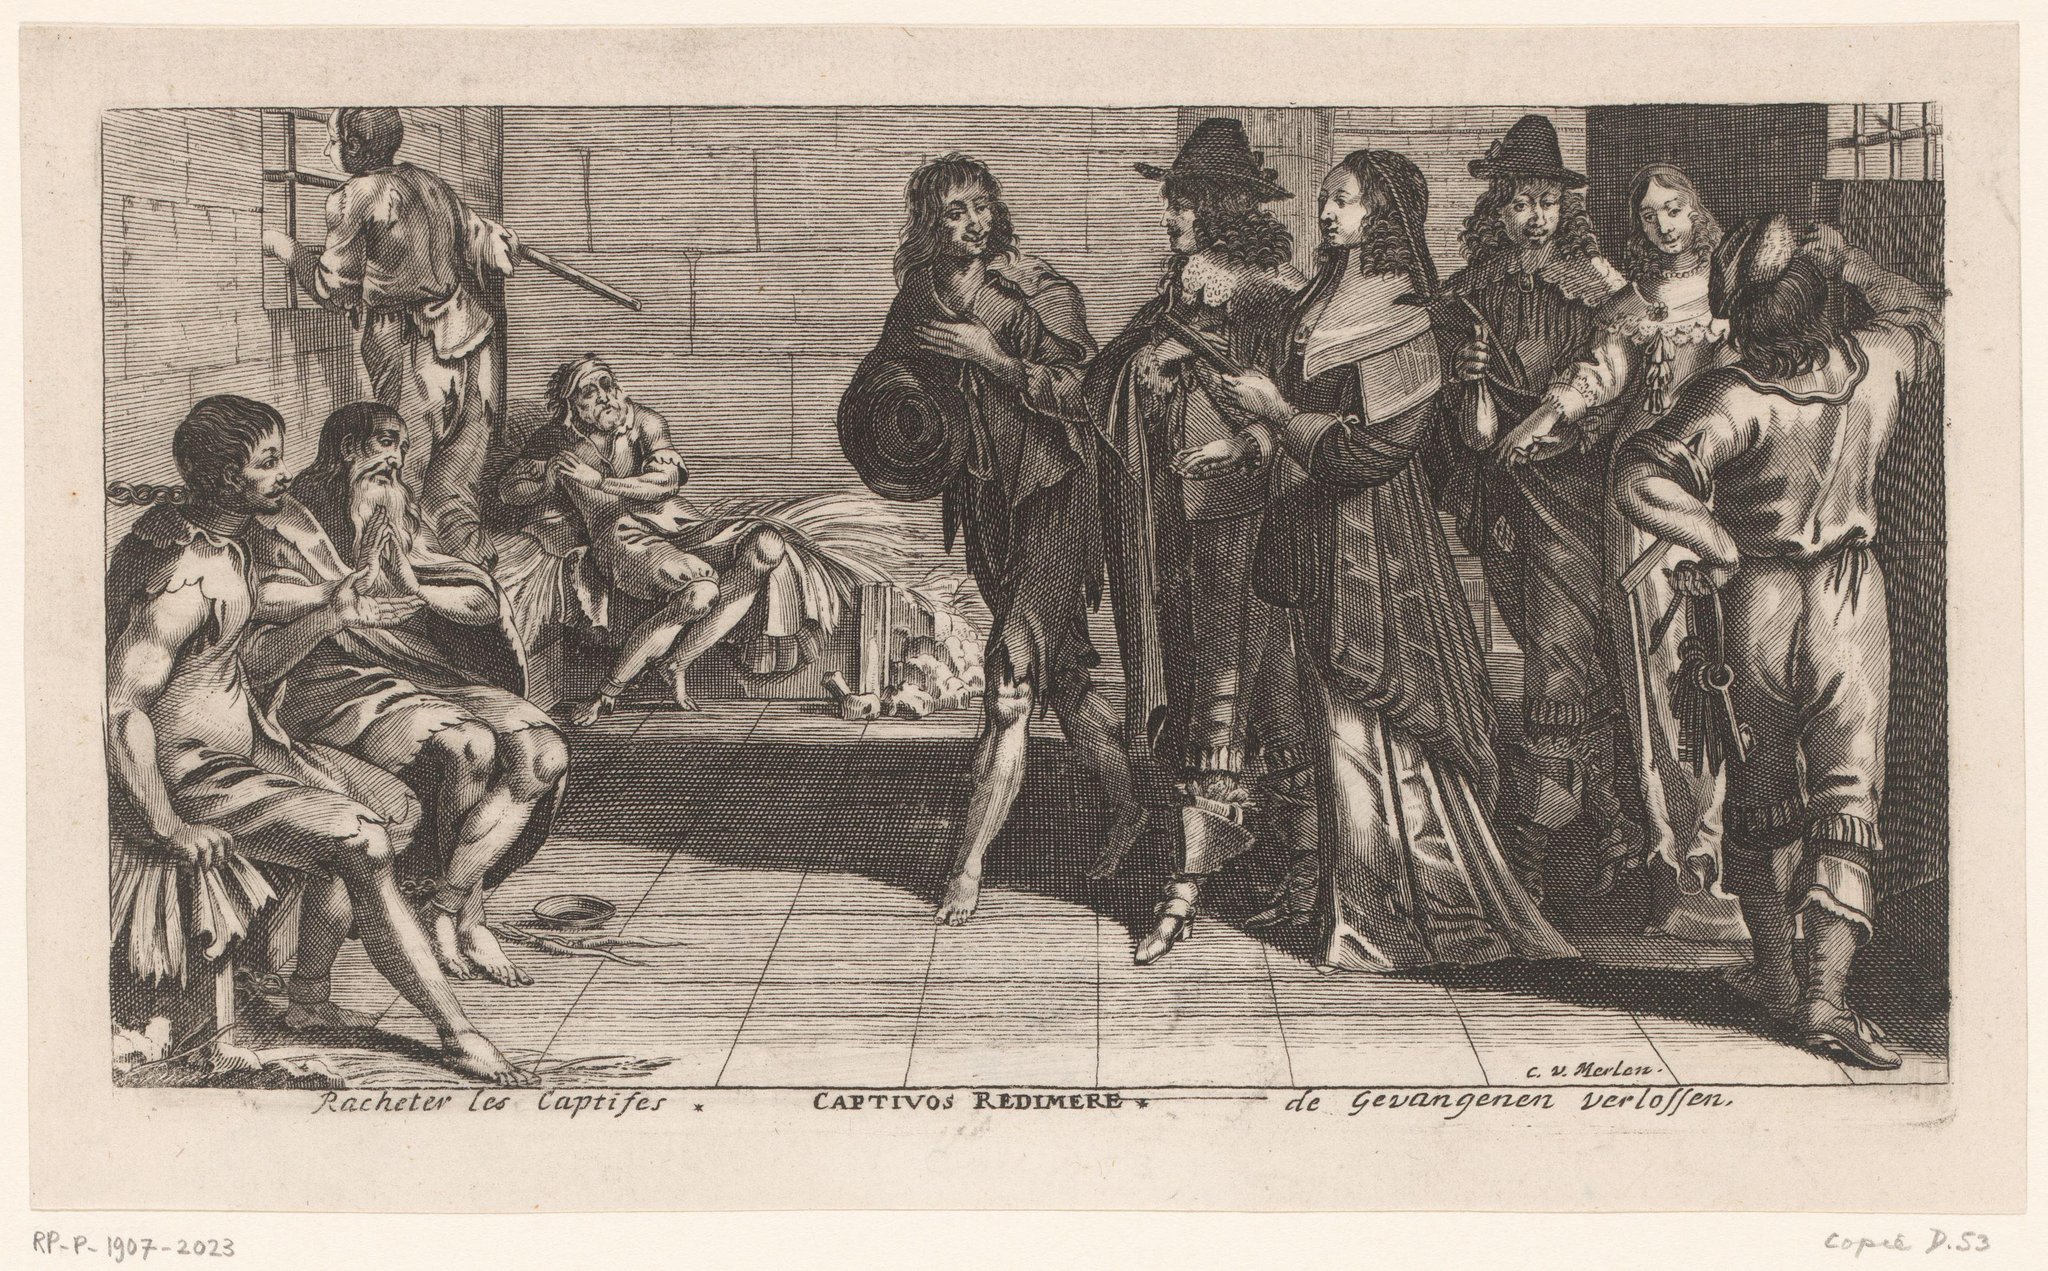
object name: print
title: Zeven werken van Barmhartigheid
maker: cornelis van merlen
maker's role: print maker, publisher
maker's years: 1654-1723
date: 1664-1723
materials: paper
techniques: engraving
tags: (prisoners) in the prison yard, visiting or liberating the imprisoned, 'incarceratus solatur' ~ one of the (seven) acts of mercy, the (seven) acts of mercy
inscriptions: collector's mark: Lugt 2228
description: Betreft een gedeeltelijke, spiegelbeeldige kopie naar een prent door Abraham Bosse uit een serie van zeven prenten met als onderwerp de zeven werken van barmhartigheid, uitgegeven tussen 1640 en 1642 door Jean Leblond (I) in Parijs. Zie Lothe 2008, nrs. 22-28.